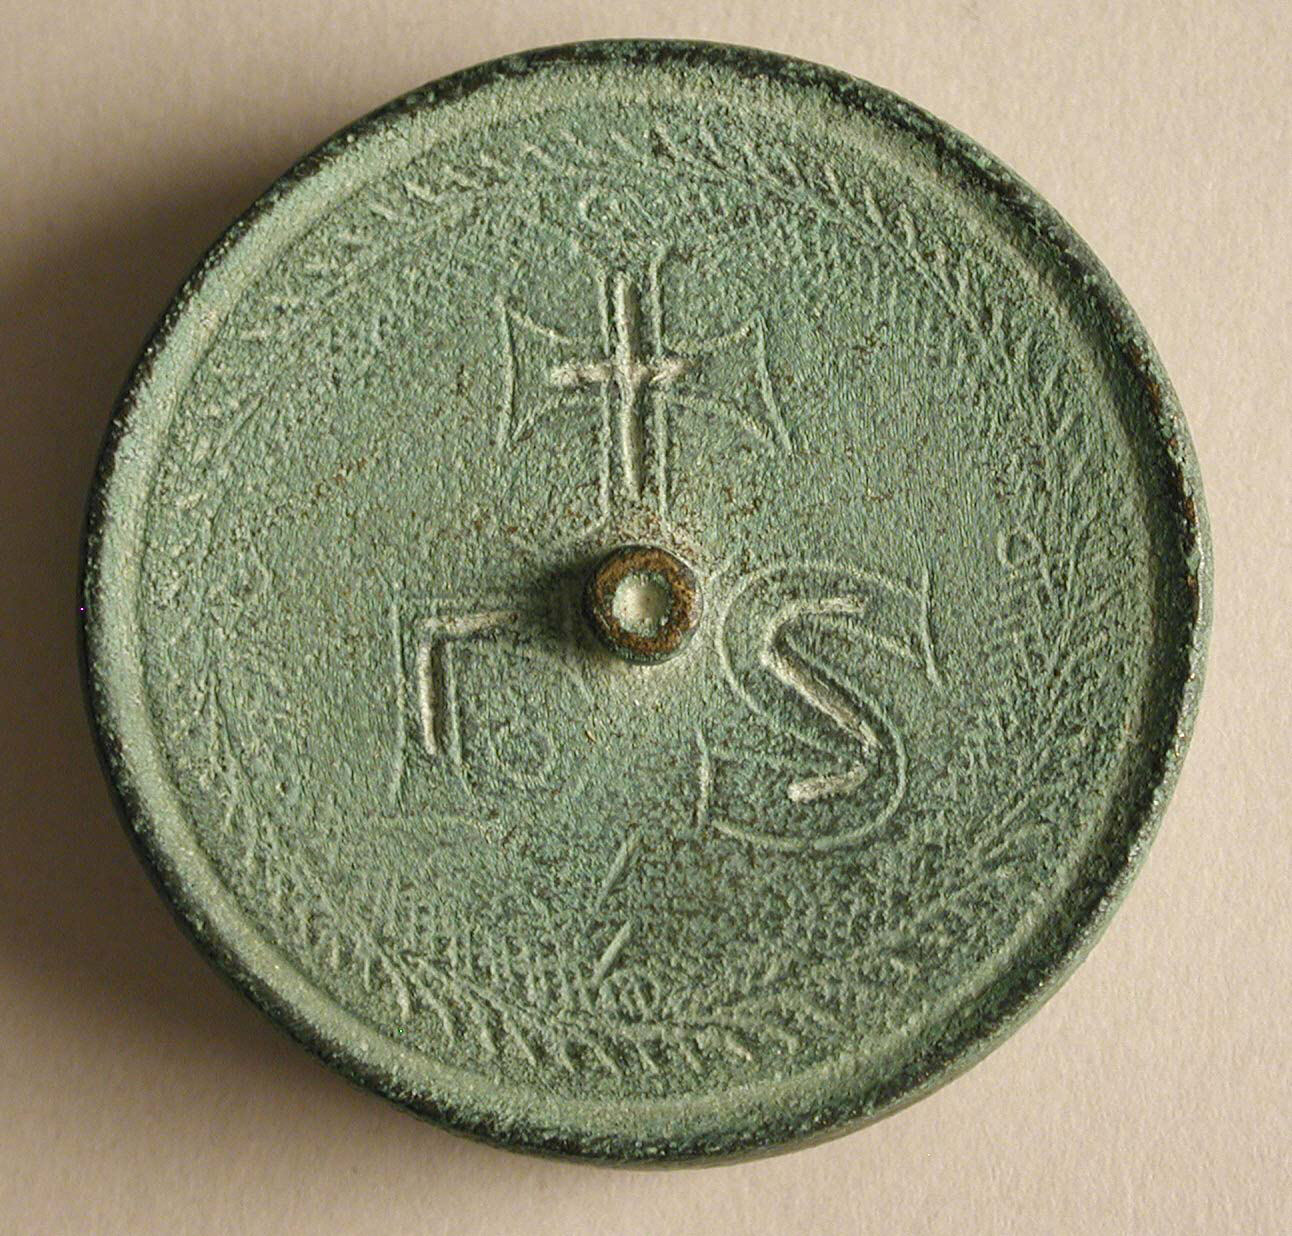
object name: weight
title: Three Round Copper-Alloy Balance Weight with Cross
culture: byzantine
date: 701-900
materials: copper alloy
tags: cross